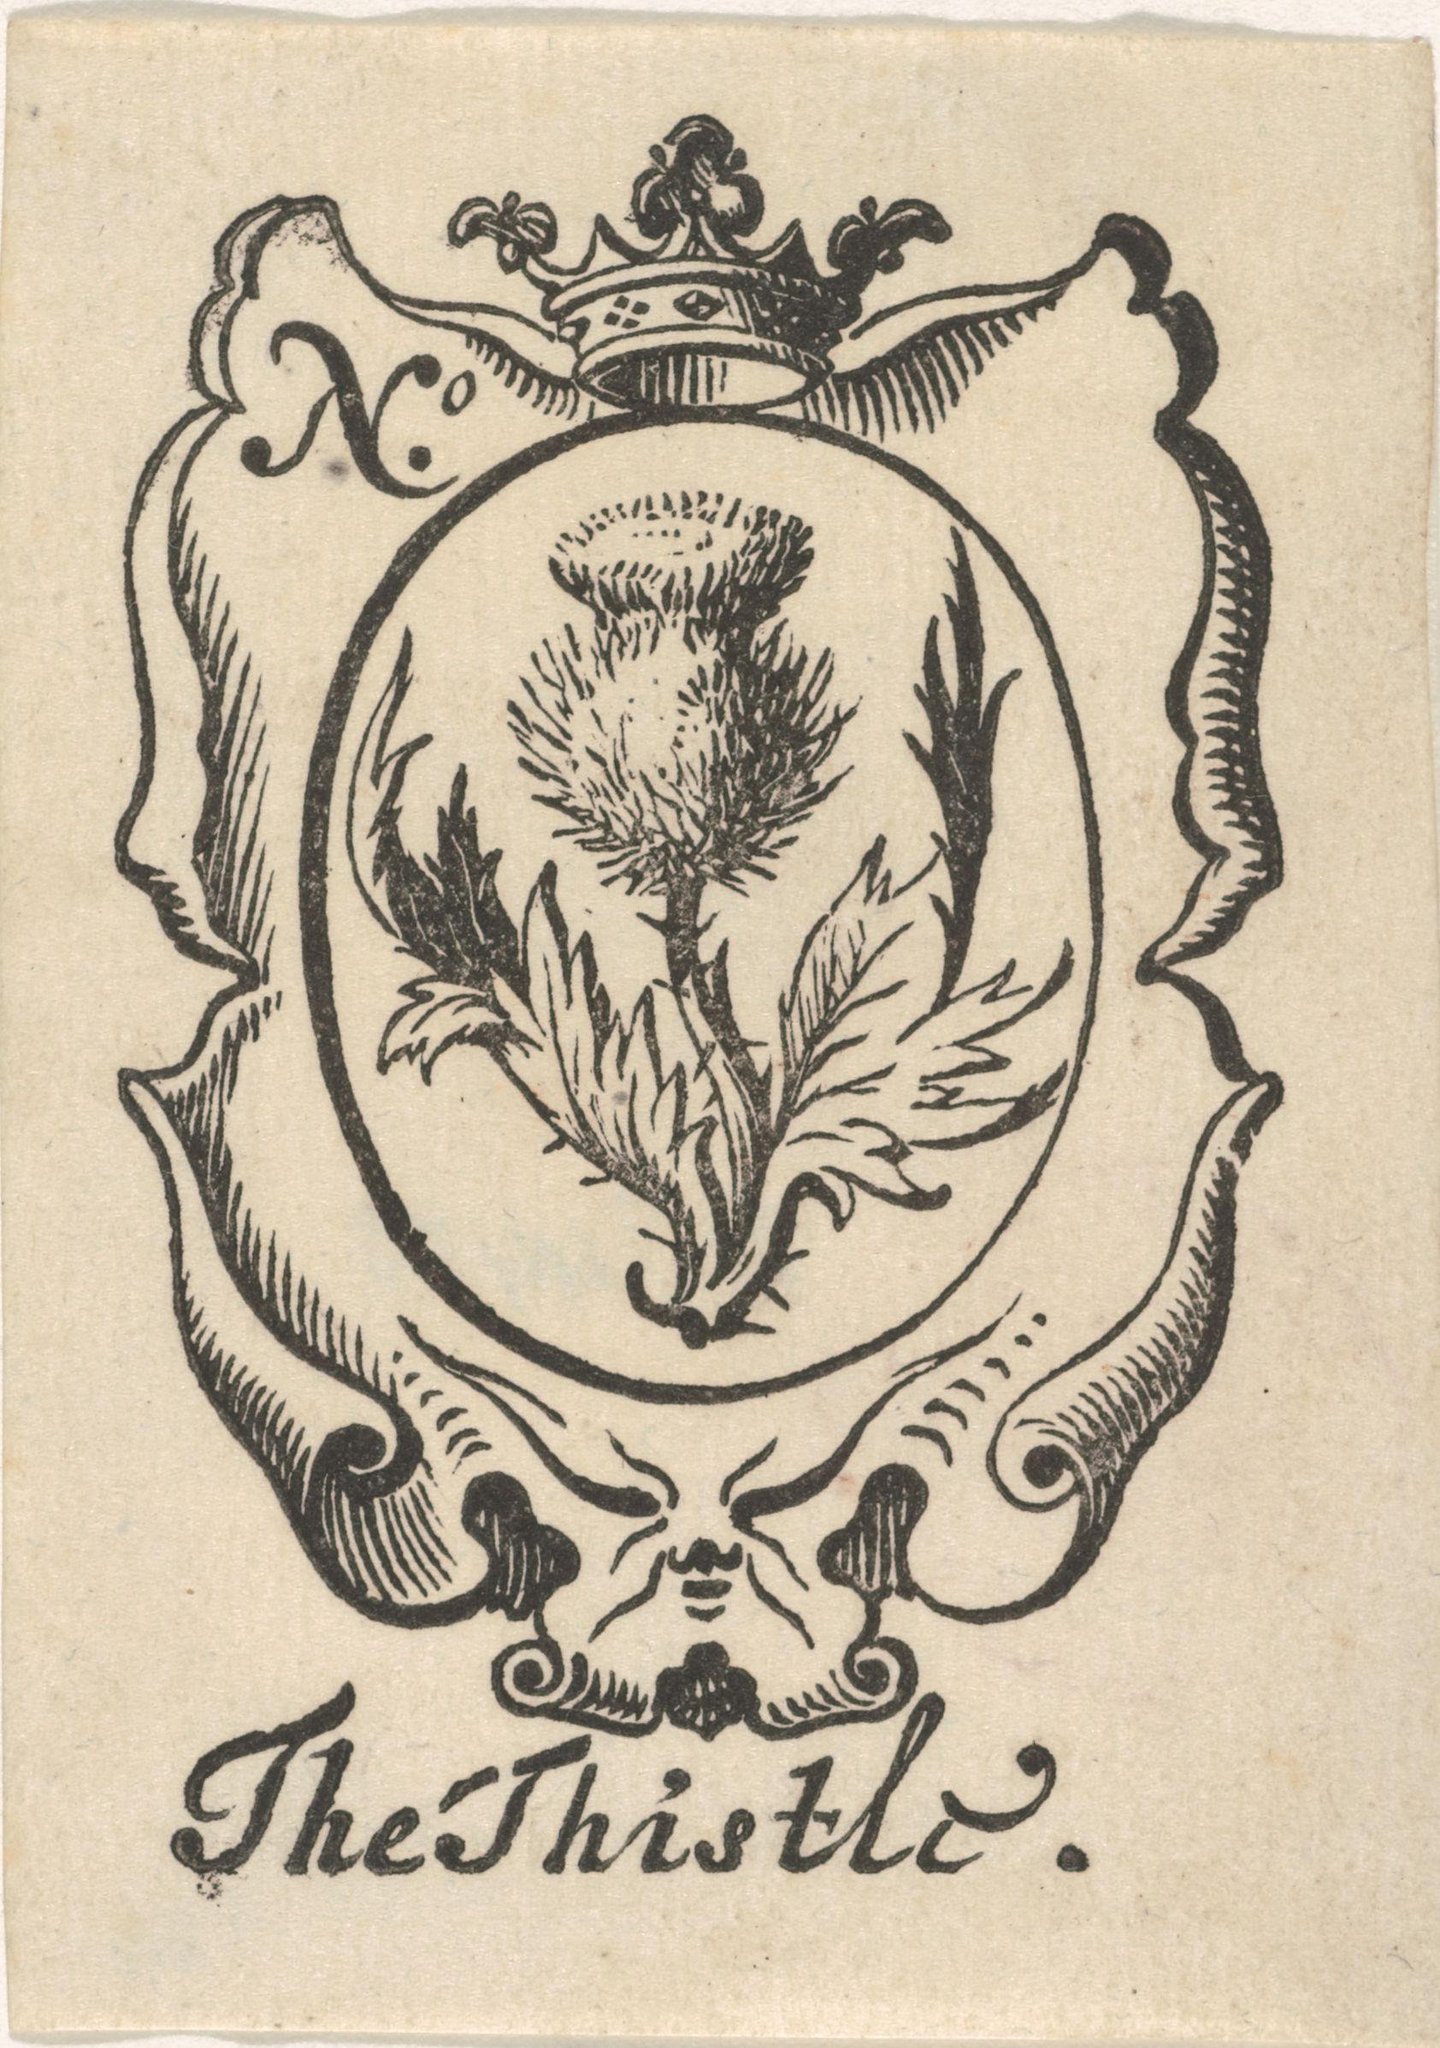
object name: handelsetiket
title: The Thistle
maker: isaac vincentsz. van der vinne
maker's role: draughtsman, print maker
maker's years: 1665-1740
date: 1681-1740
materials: paper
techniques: woodcut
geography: haarlem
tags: crown (symbol of sovereignty), vignette, plants and herbs: thistle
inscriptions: collector's mark: Lugt 240